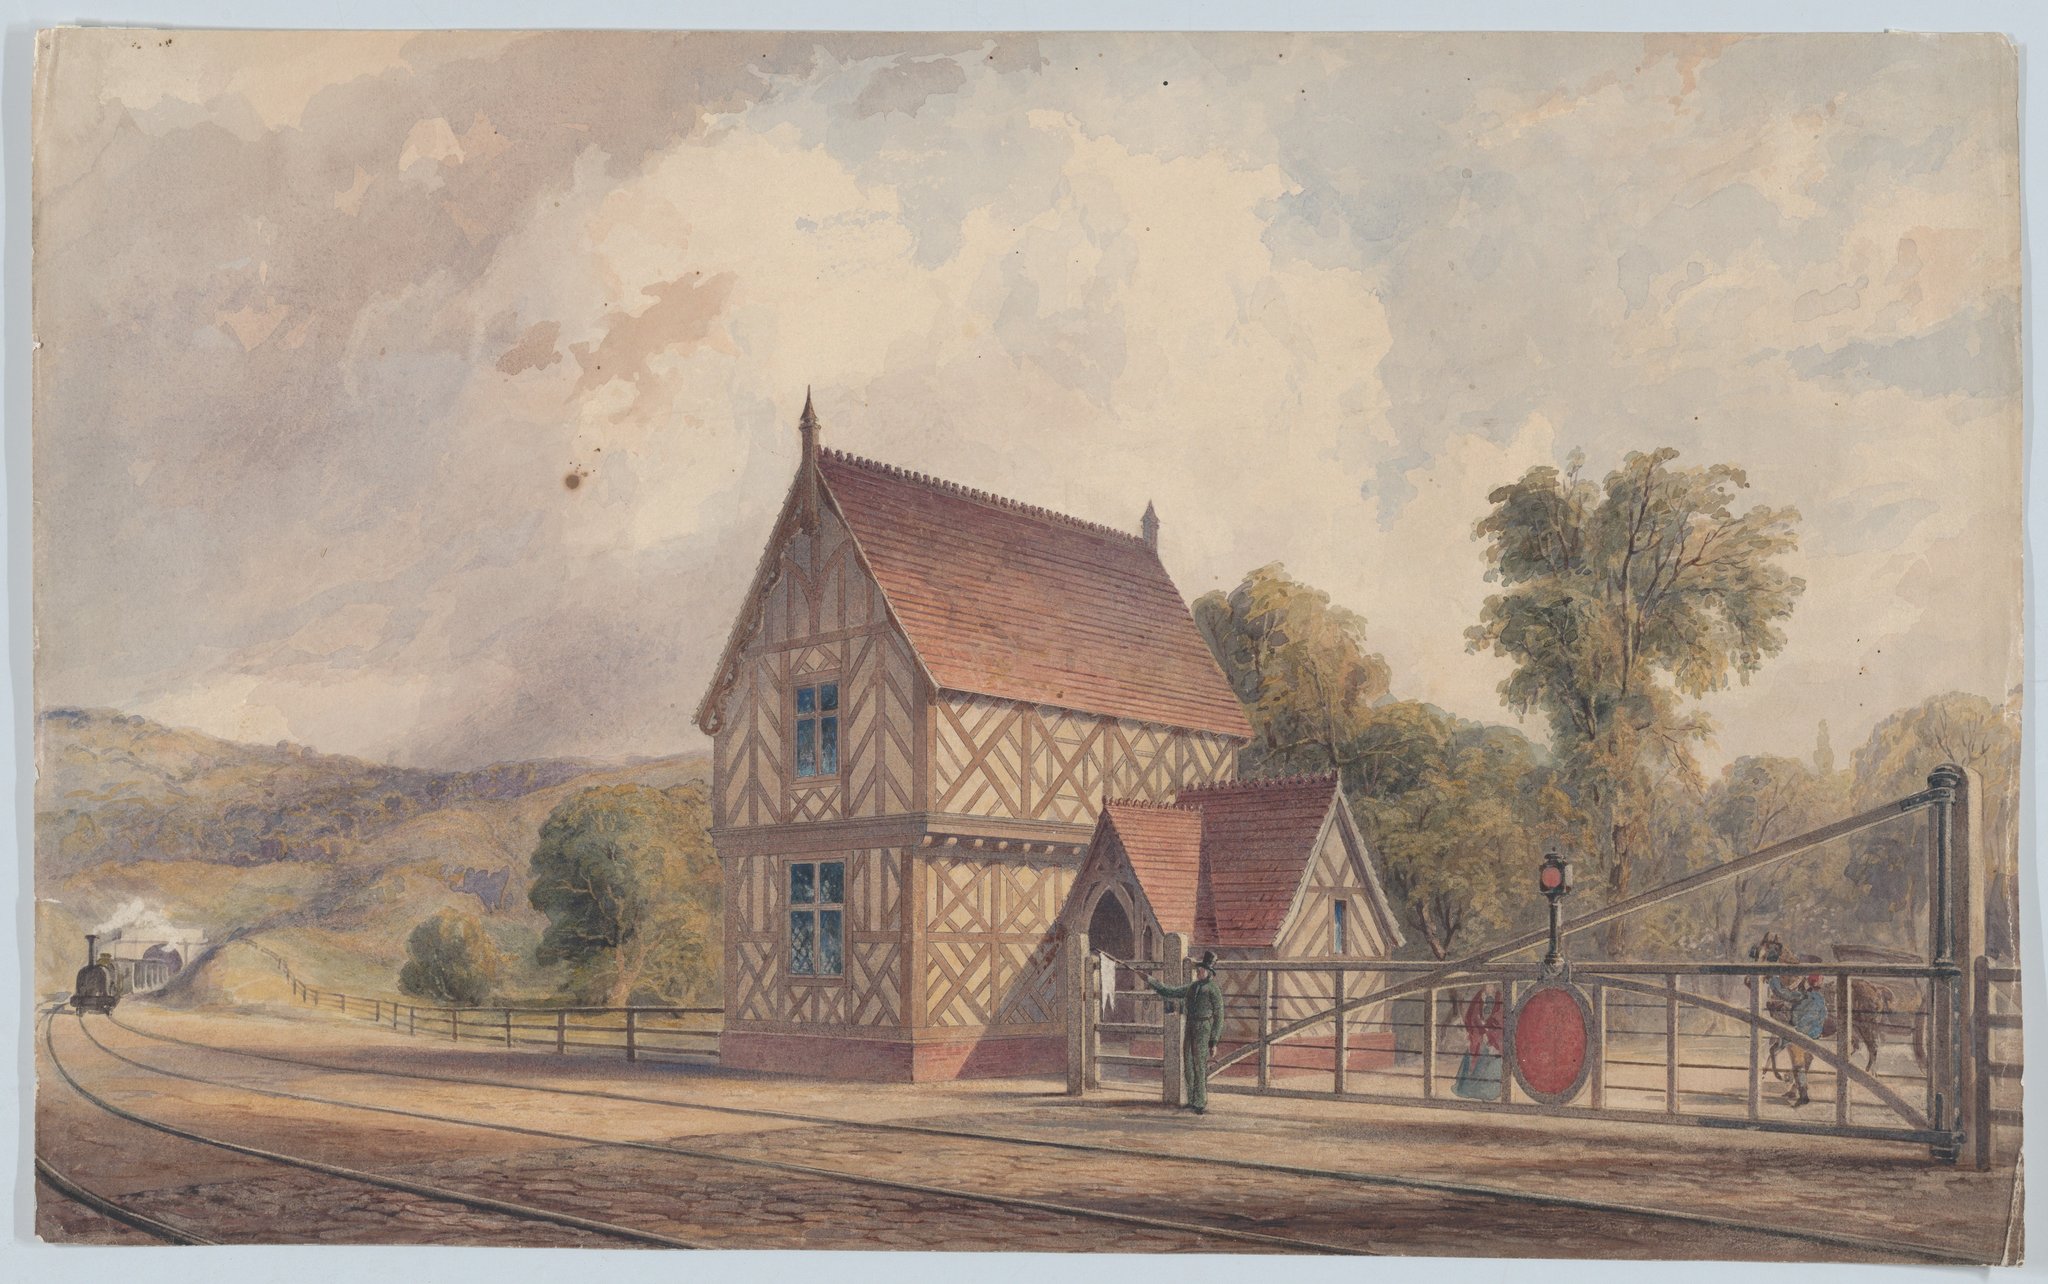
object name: drawing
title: Tudor Style Rural Train Station and Railroad Crossing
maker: john connell ogle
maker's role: artist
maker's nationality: british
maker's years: 1813-1877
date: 1844-1877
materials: watercolor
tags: train stations,railways